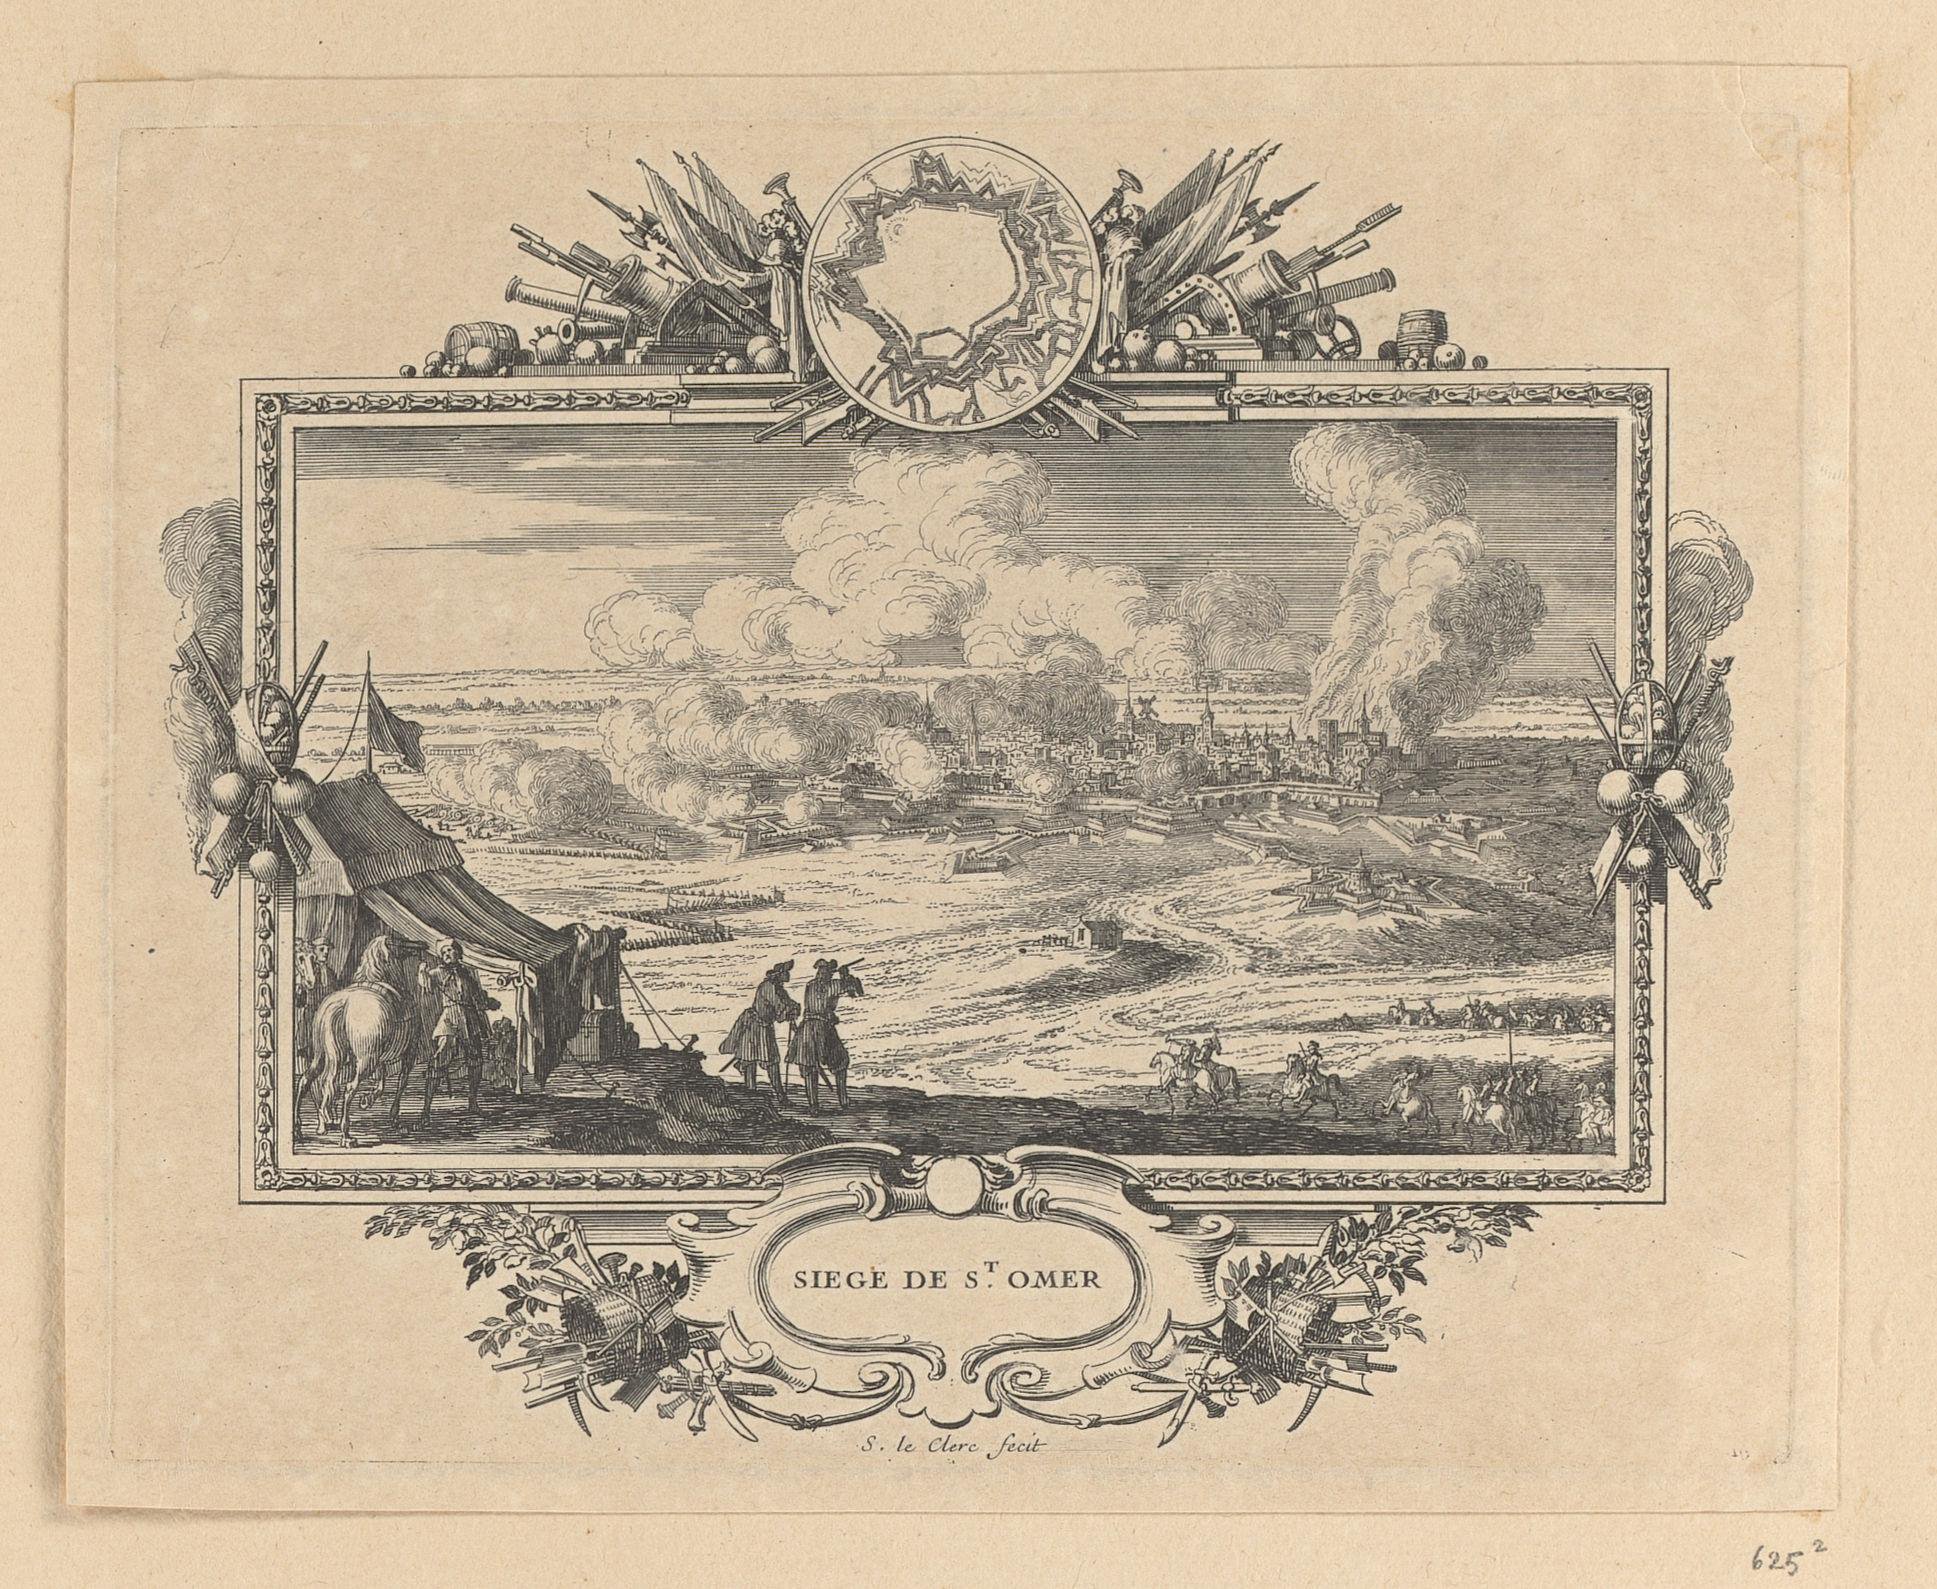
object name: print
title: Kleine overwinningen van koning Lodewijk XIV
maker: sébastien leclerc (i)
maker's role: print maker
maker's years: 1637-1714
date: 1702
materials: paper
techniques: engraving, etching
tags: siege